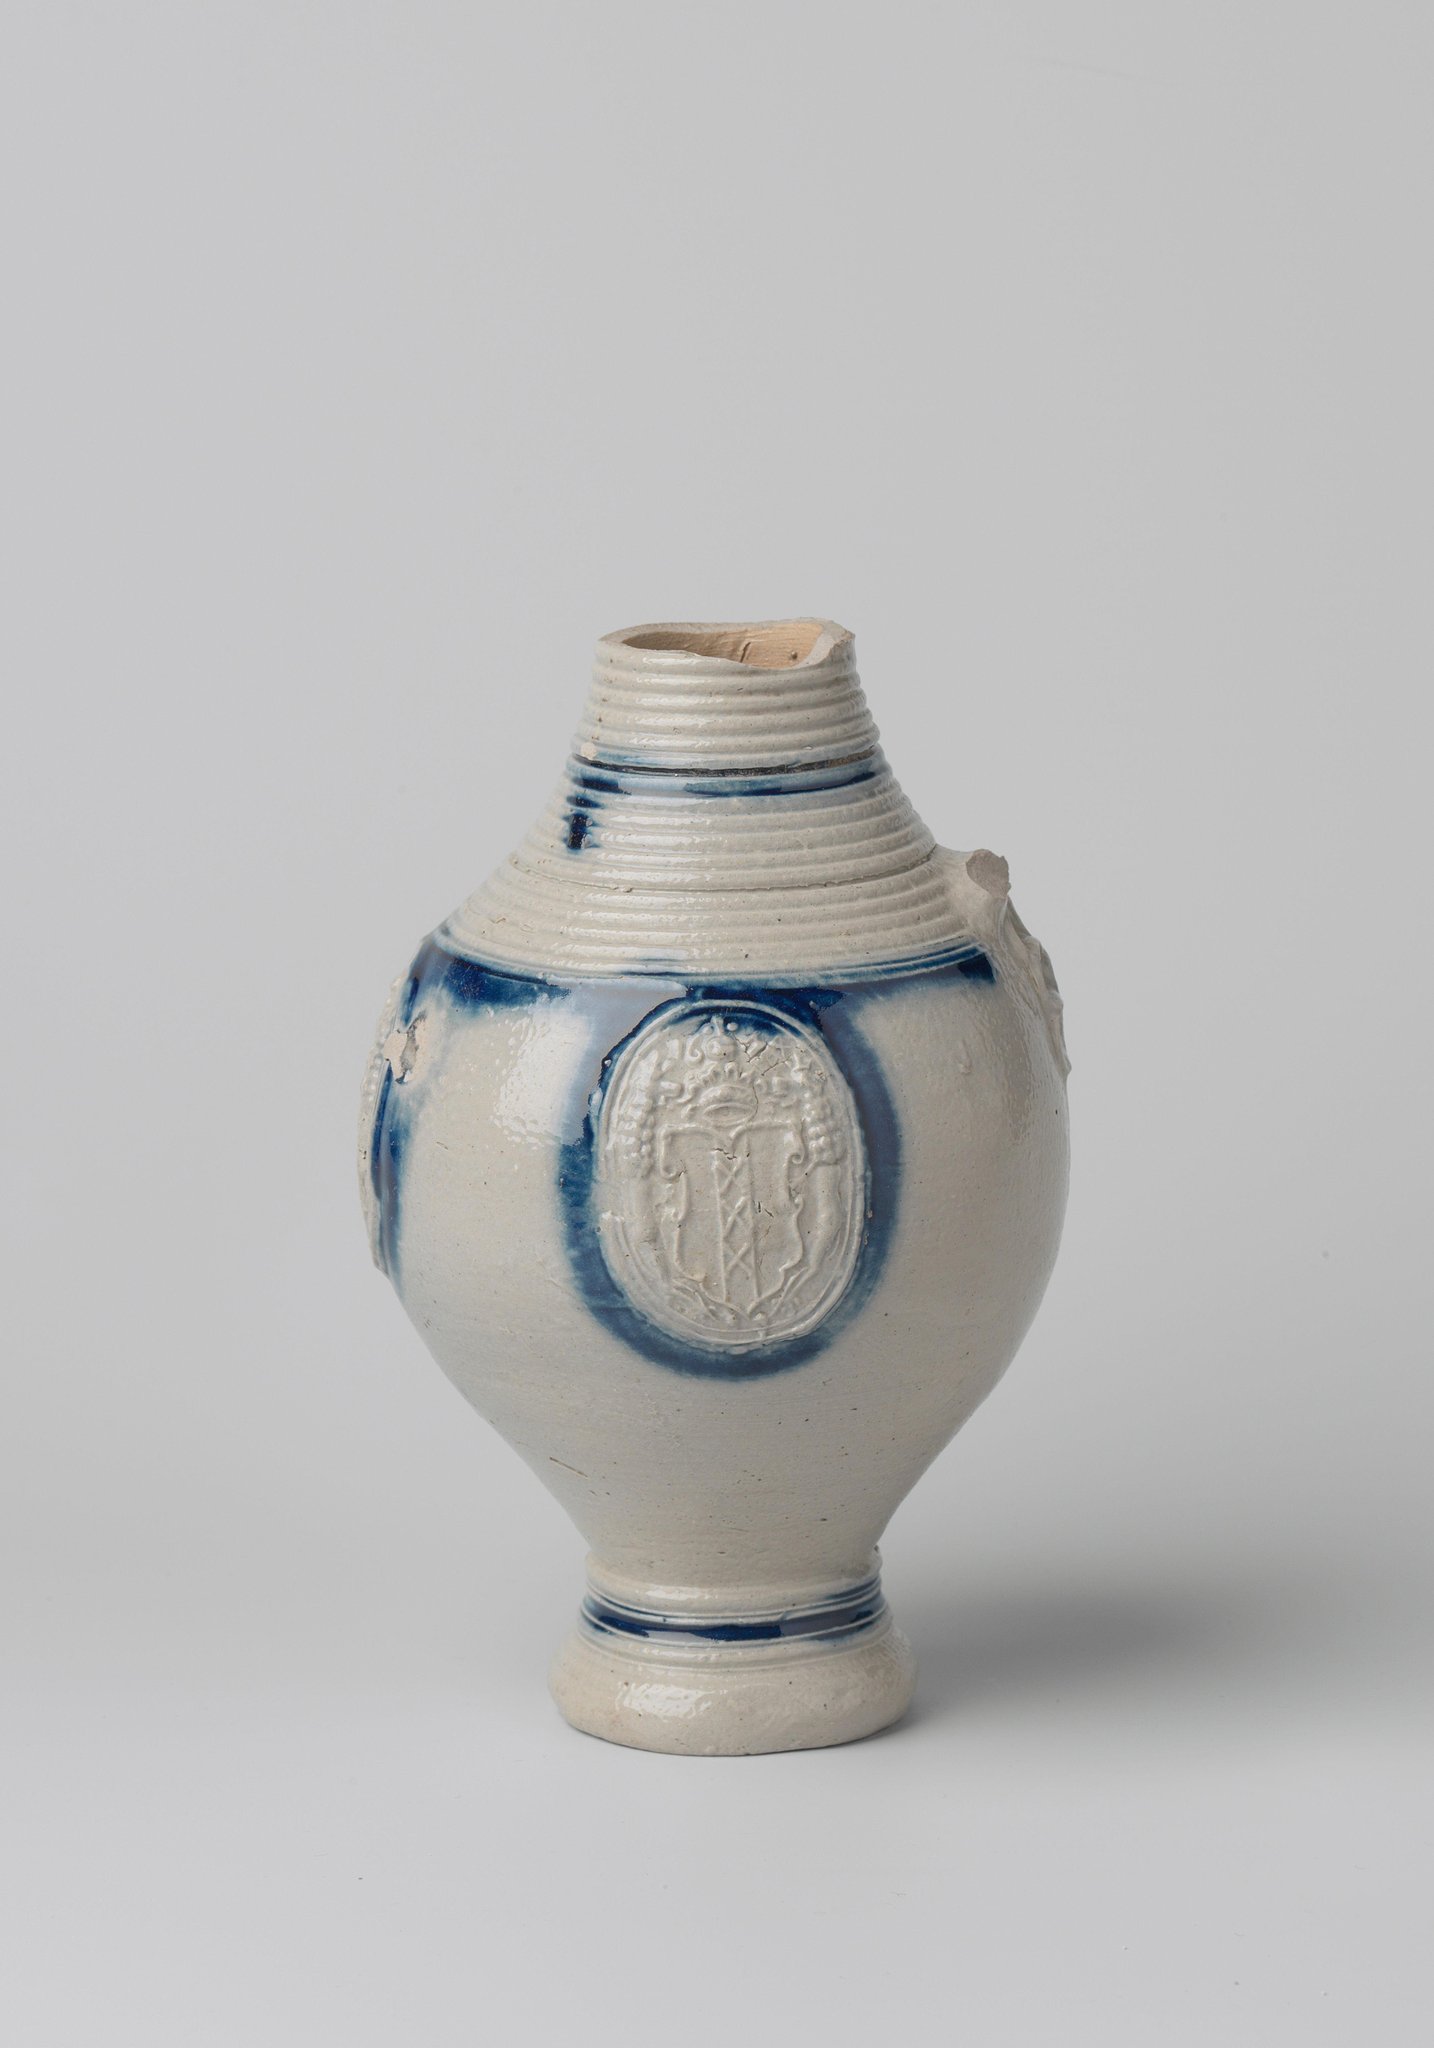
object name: fragment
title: Fragment of a jug with the coat of arms of Amsterdam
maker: Anonymous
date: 1644-1660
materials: cobalt, glaze, stoneware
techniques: firing, forming, relief, turning, vitrification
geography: westerwald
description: Fragment van een kruik van steengoed op hoge voet met een eivormig lichaam en een taps toelopende nek. Bovenste deel van de nek en het oor ontbreken. Het C-vormige oor was bevestigd aan de schouder. Een brede band met ingegrifte lijnen op de nek, enkele op de voet. Gedeeltelijk bedekt met kobaltblauw. Op de buik driemaal een gedrukt en opgelegd medaillon met het wapen van Amsterdam en het opschrift '1644' in reliëf. Westerwald.